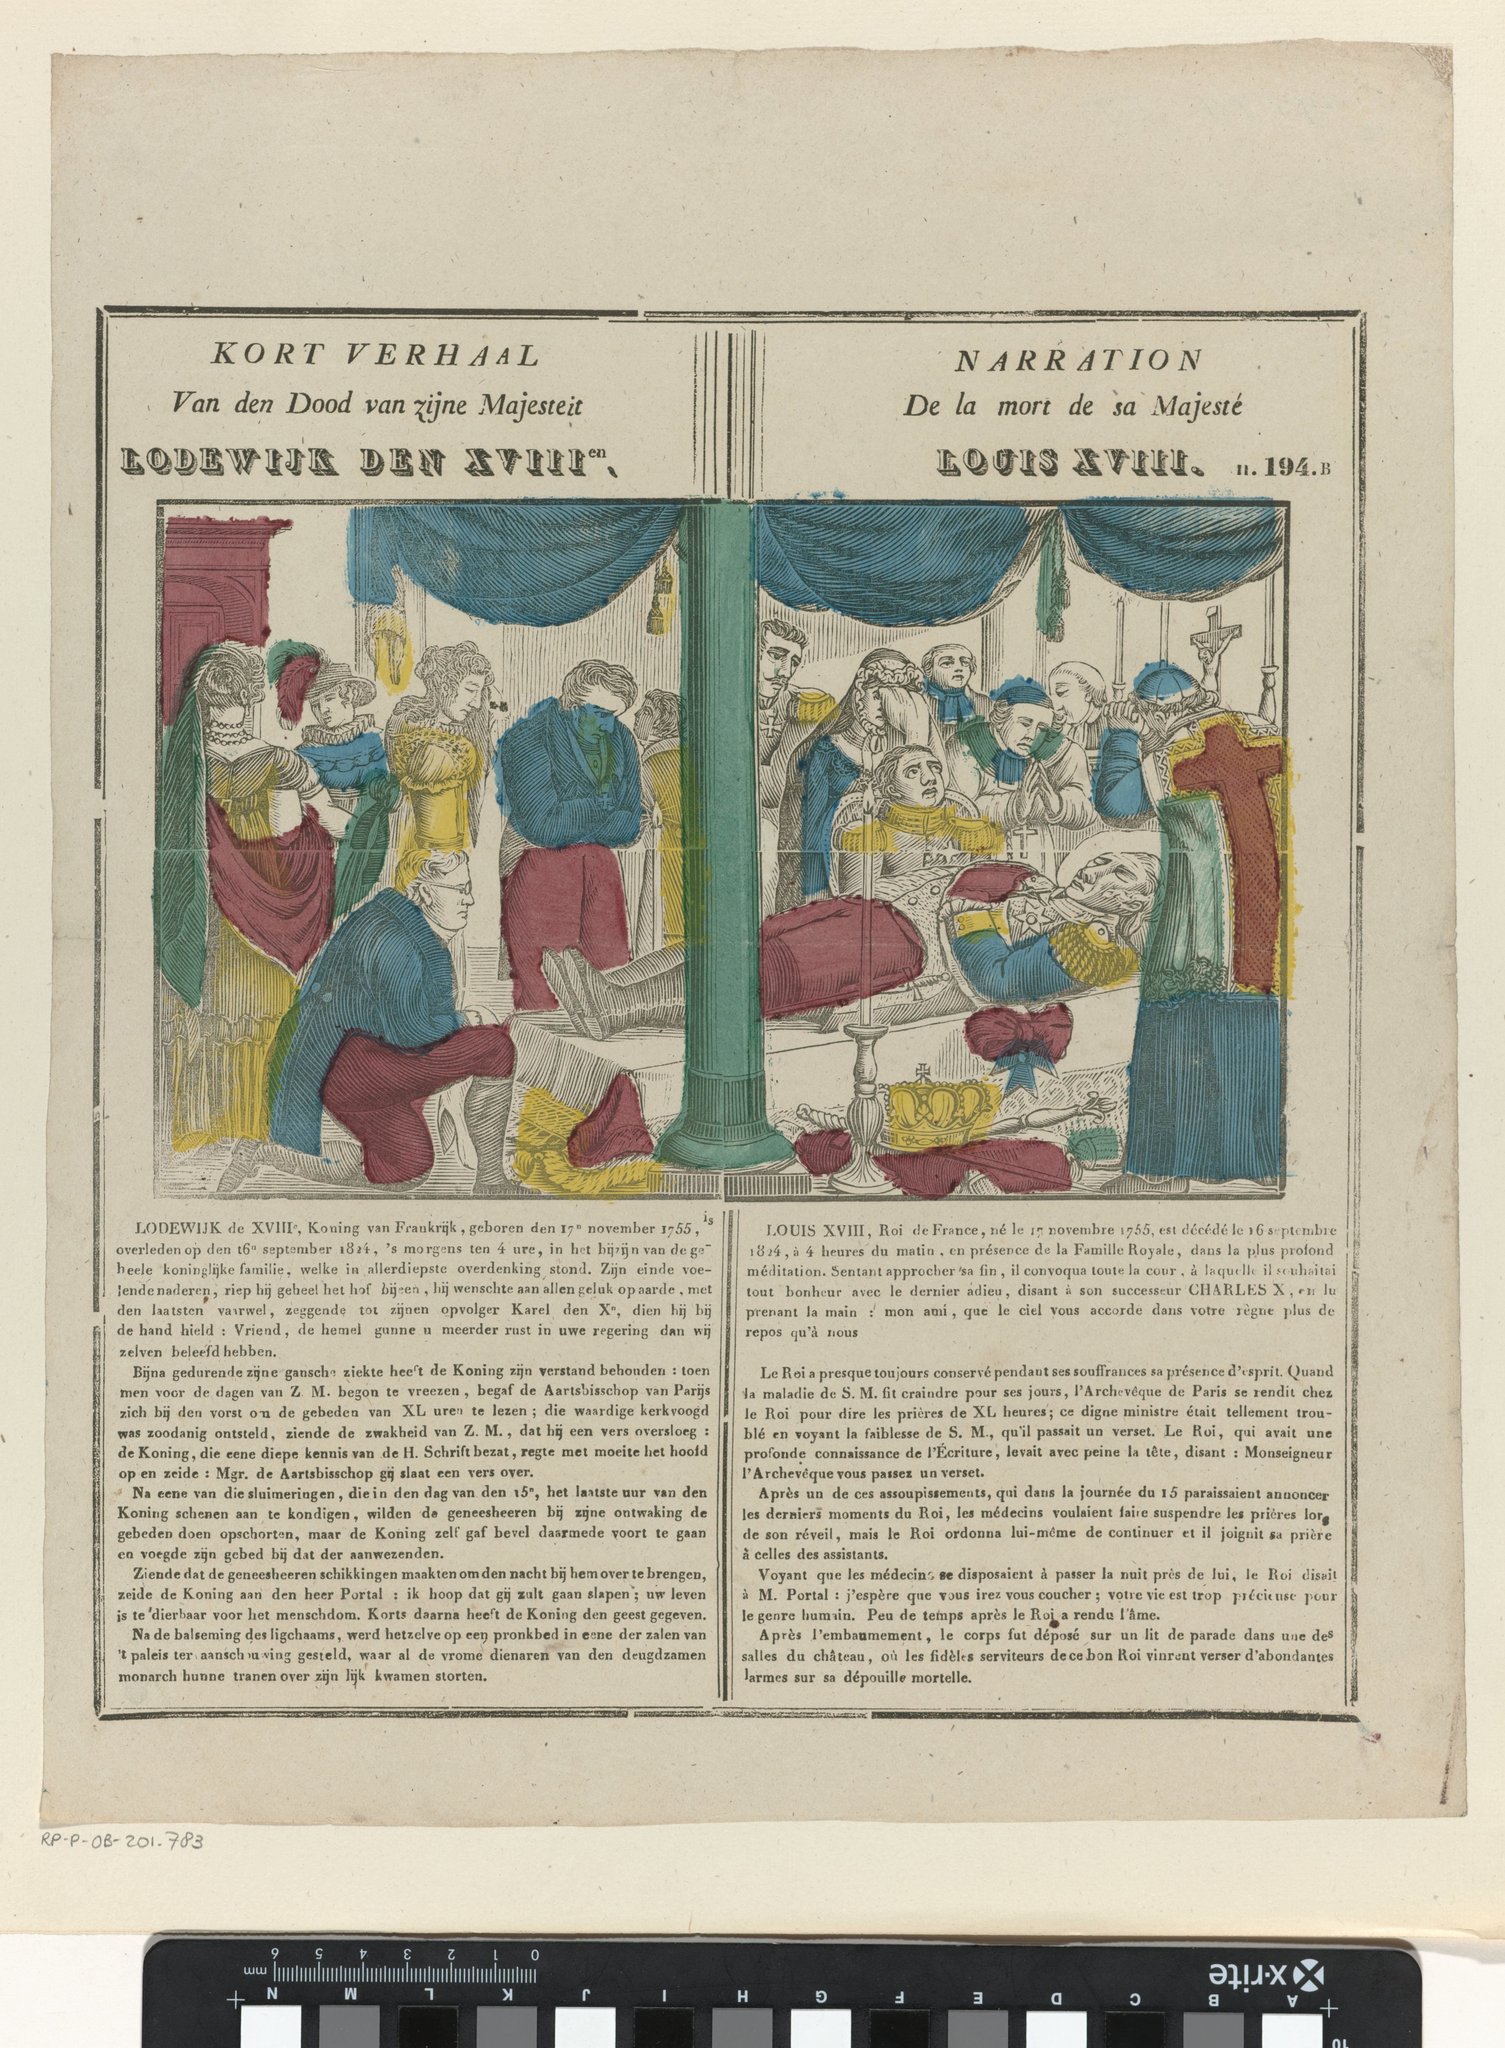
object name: print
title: Kort verhaal / Van den dood van zijne majesteit / Lodewijk den XVIIIen / Narration / De la mort de sa Majesté / Louis XVIII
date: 1800-1833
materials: paper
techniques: colour, letterpress printing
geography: turnhout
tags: paris, lodewijk xviii (koning van frankrijk), mourning the dead, lying in state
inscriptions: collector's mark: Lugt 2760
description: Koning Lodewijk XVIII ligt opgebaard onder een baldakijn. Hovelingen staan rouwend om zijn lichaam. Onder de afbeelding een onderschrift in het Nederlands en in het Frans in twee kolommen. Genummerd rechtsboven: n. 194. B.